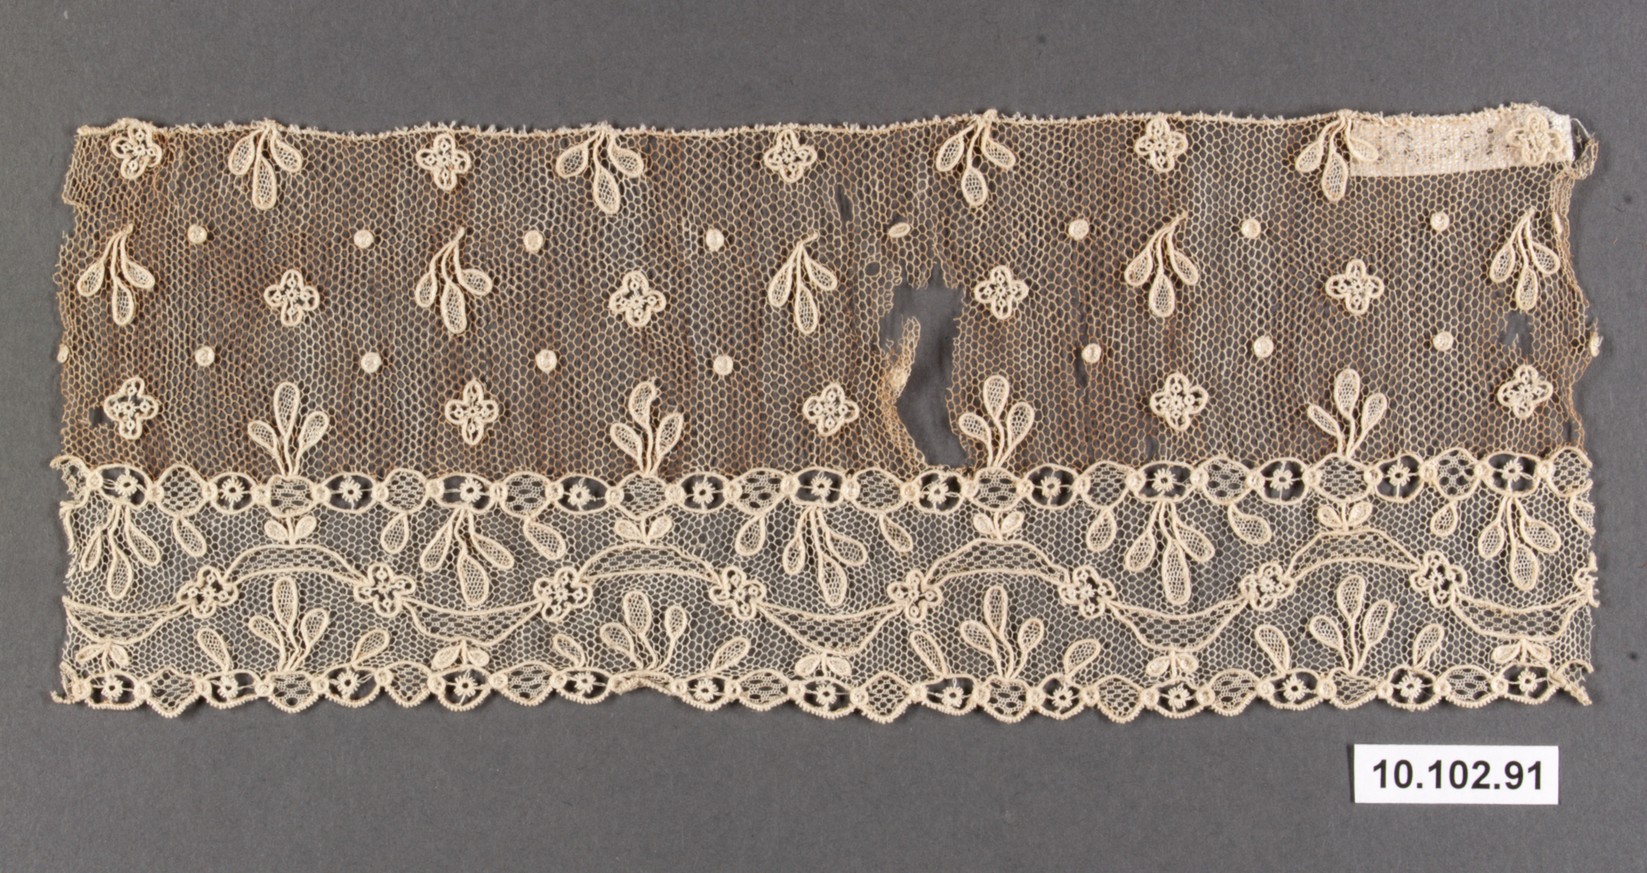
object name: fragment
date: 1767-1800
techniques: lace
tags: leaves